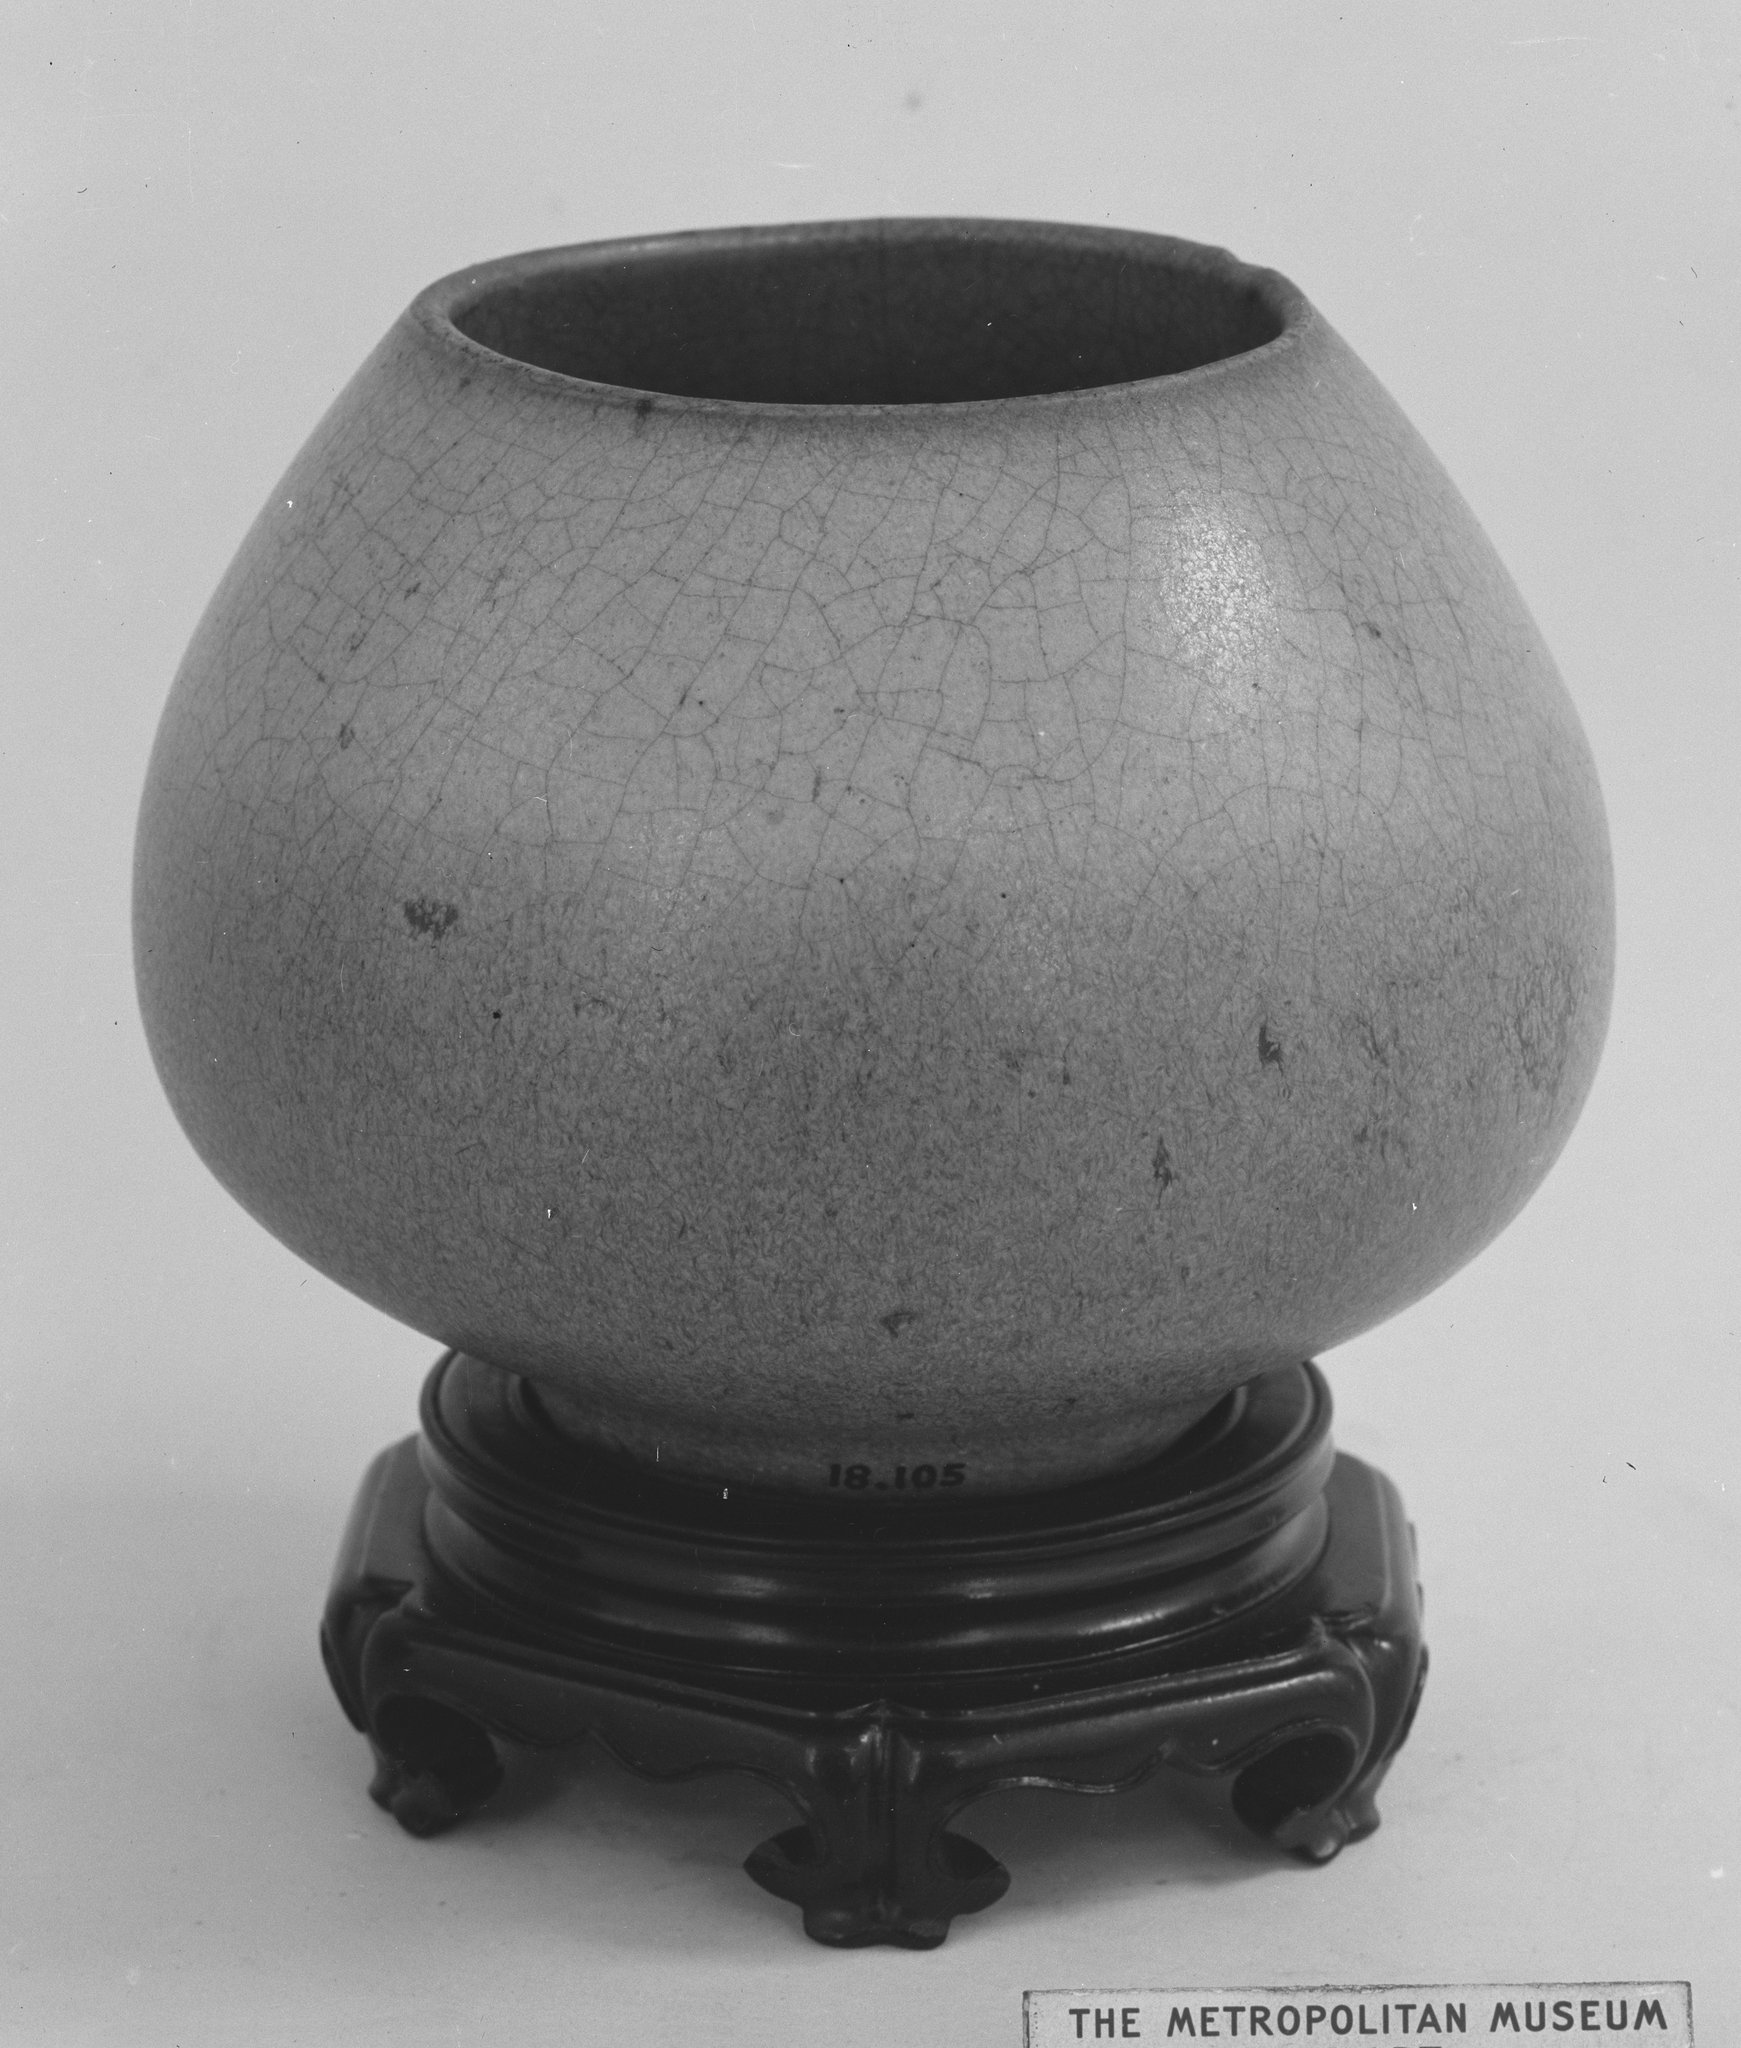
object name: jar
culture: chinese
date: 960-1279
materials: pottery